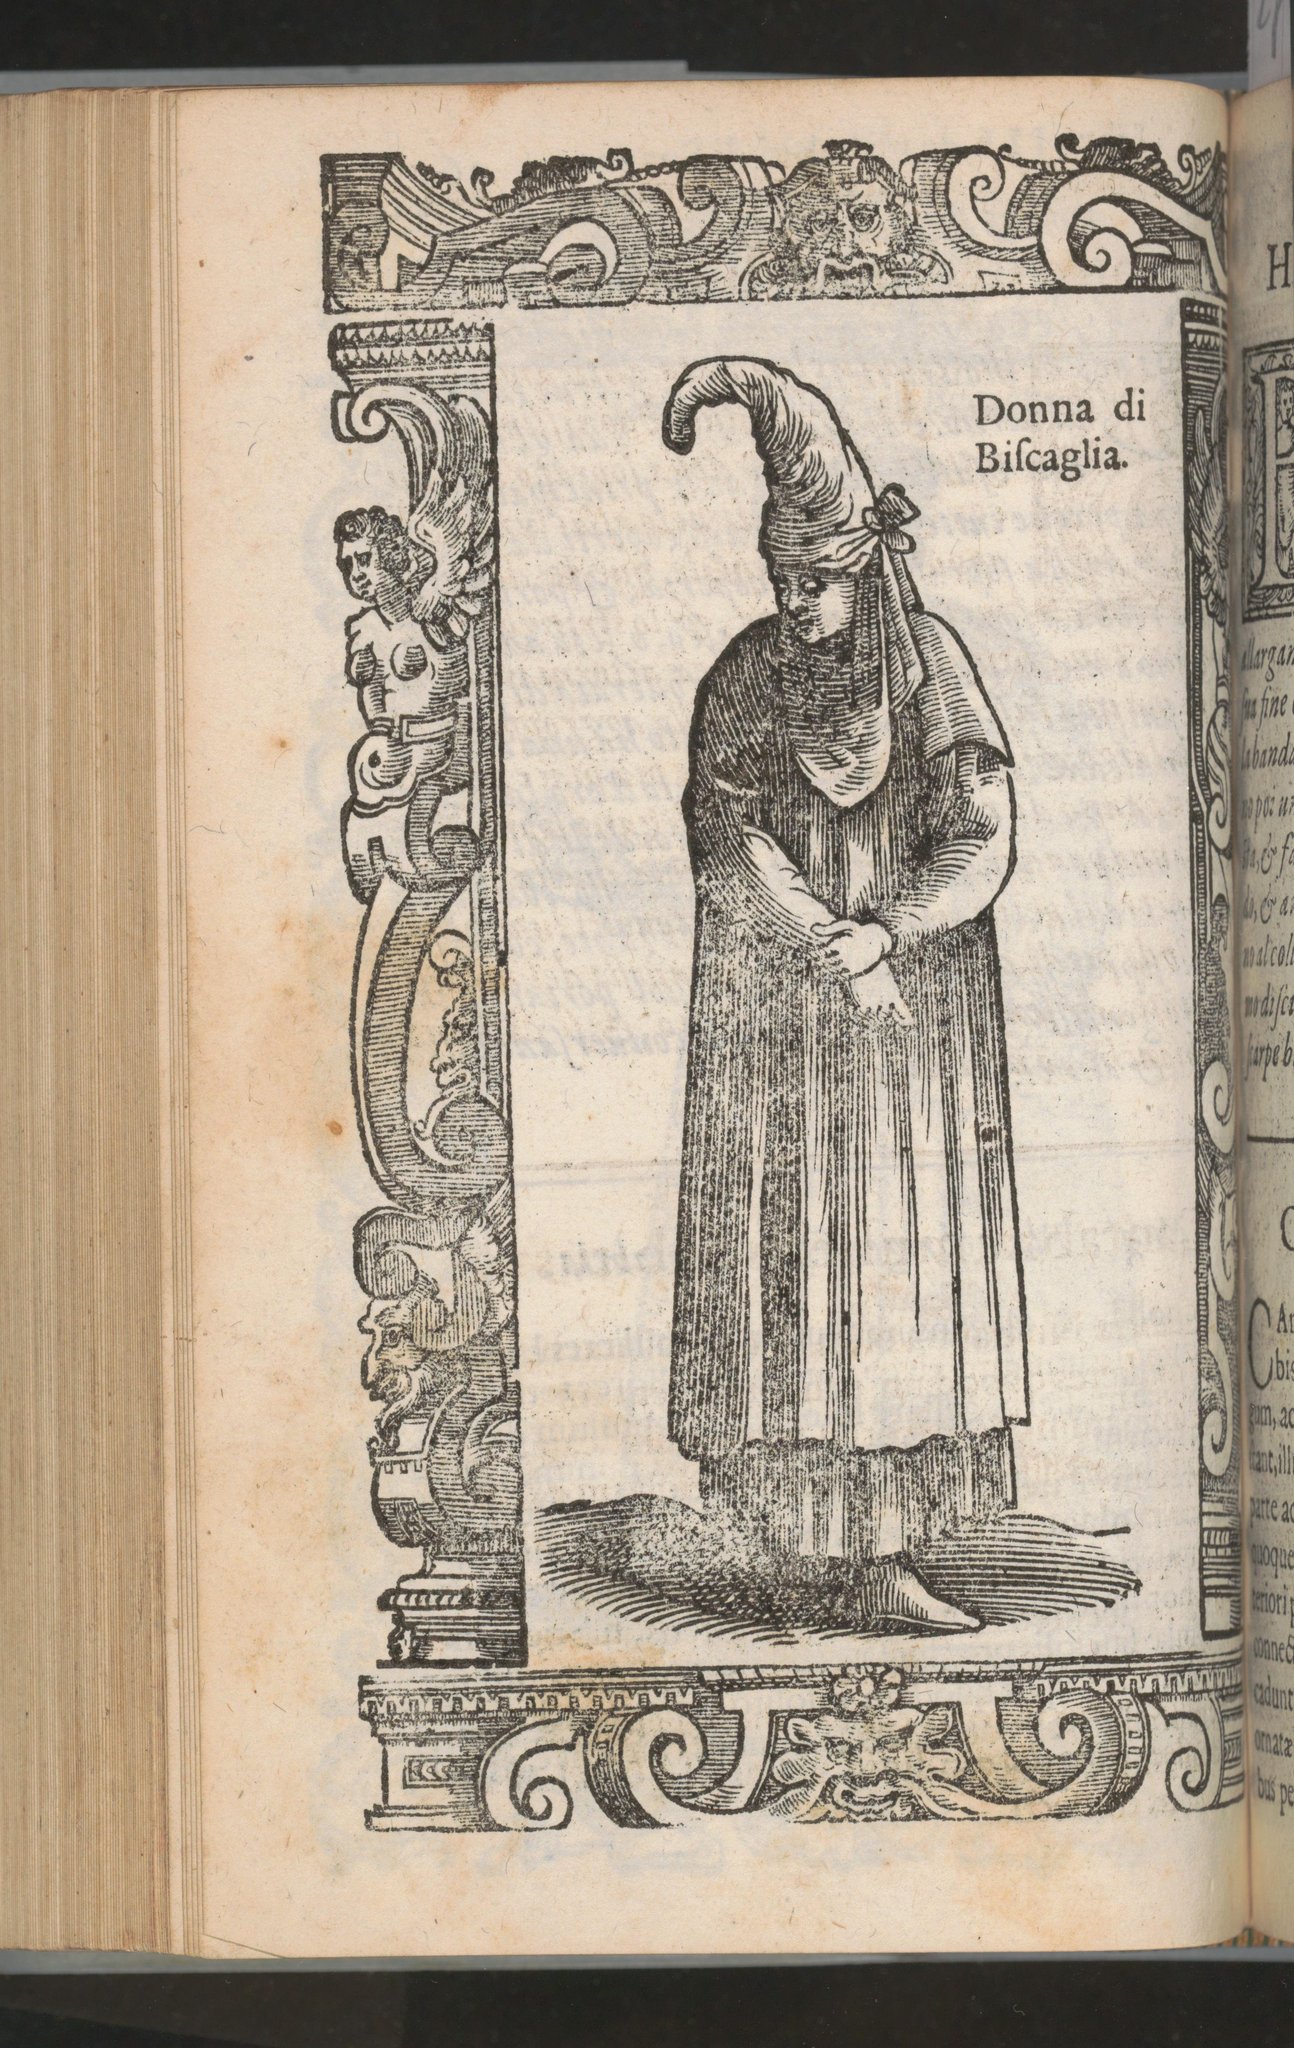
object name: costume print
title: Donna di Biscaglia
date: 1598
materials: paper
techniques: woodcut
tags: veil (+ women's clothes), fashion plates, head-gear: hat (+ women's clothes), dress, gown (+ women's clothes)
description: Vrouw uit Biskaje, met op het hoofd een hoge muts van fluweel die in een punt uitloopt. Onder de kin hangt een stuk stof dat kin en borst bedekt. Sober wollen overkleed dat iets korter is dan het enkellang onderkleed.